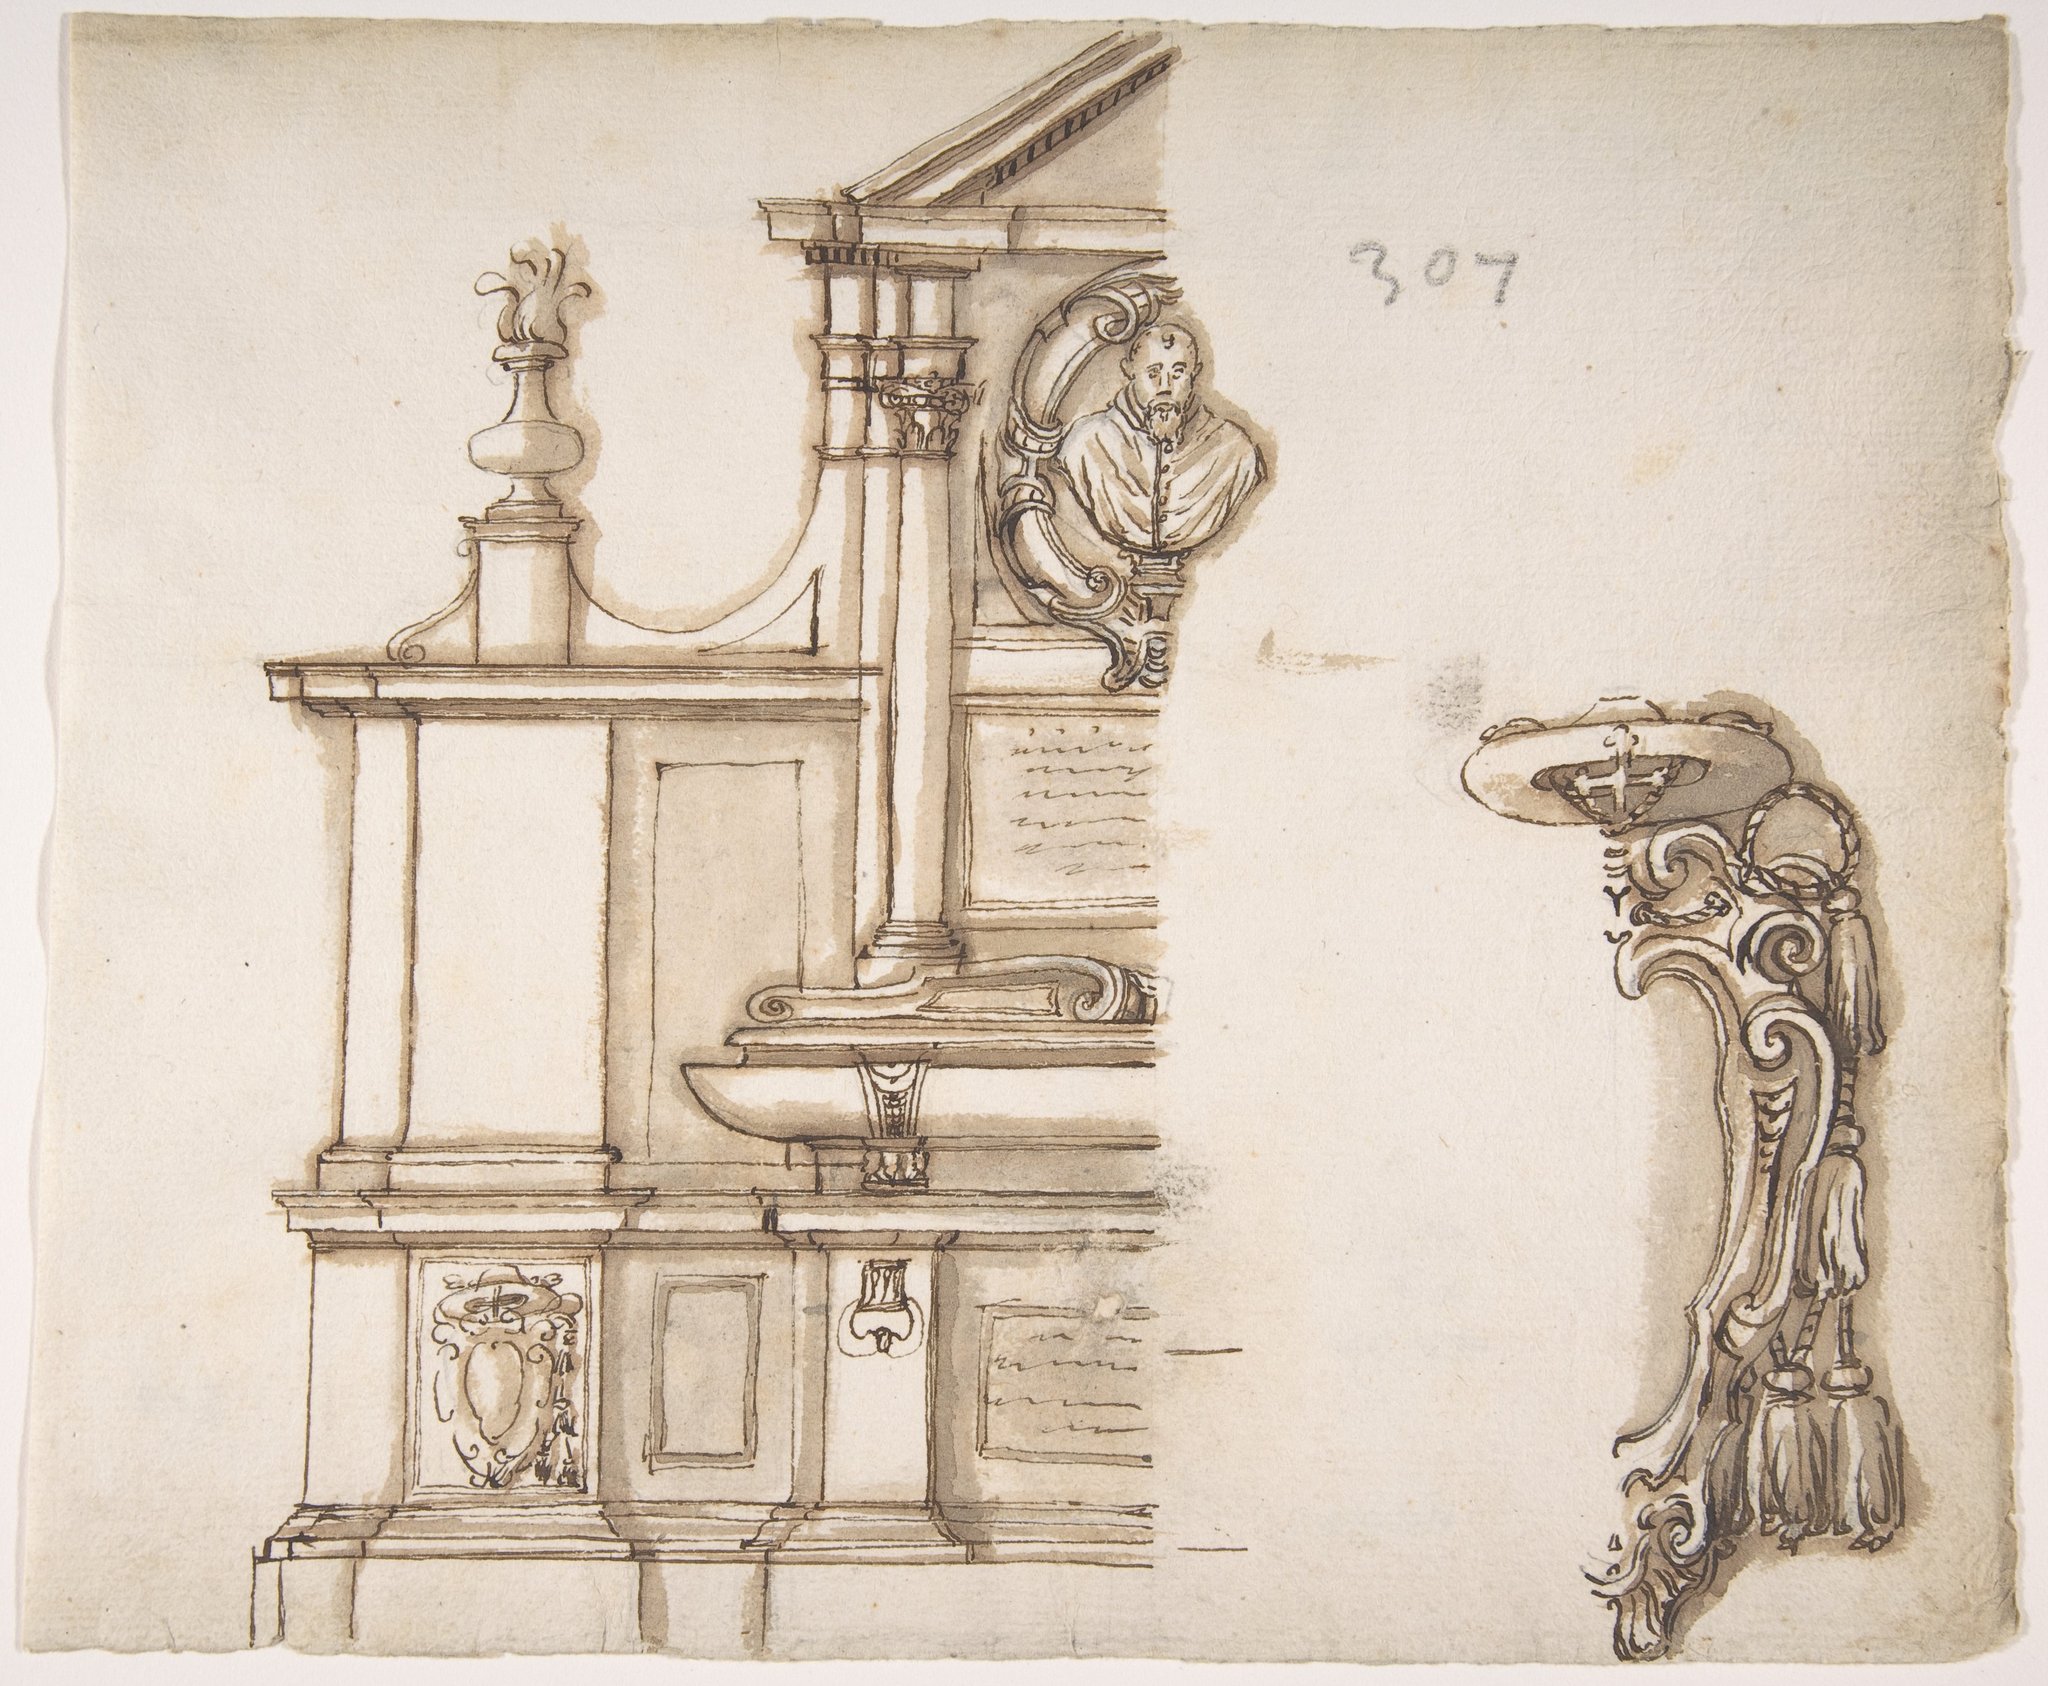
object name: drawing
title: Design for a Tomb for a Cardinal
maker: anonymous, french, 16th century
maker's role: artist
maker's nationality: french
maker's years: 1500-1600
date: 1501-1600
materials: ink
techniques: brush, pen, wash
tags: tombs,men